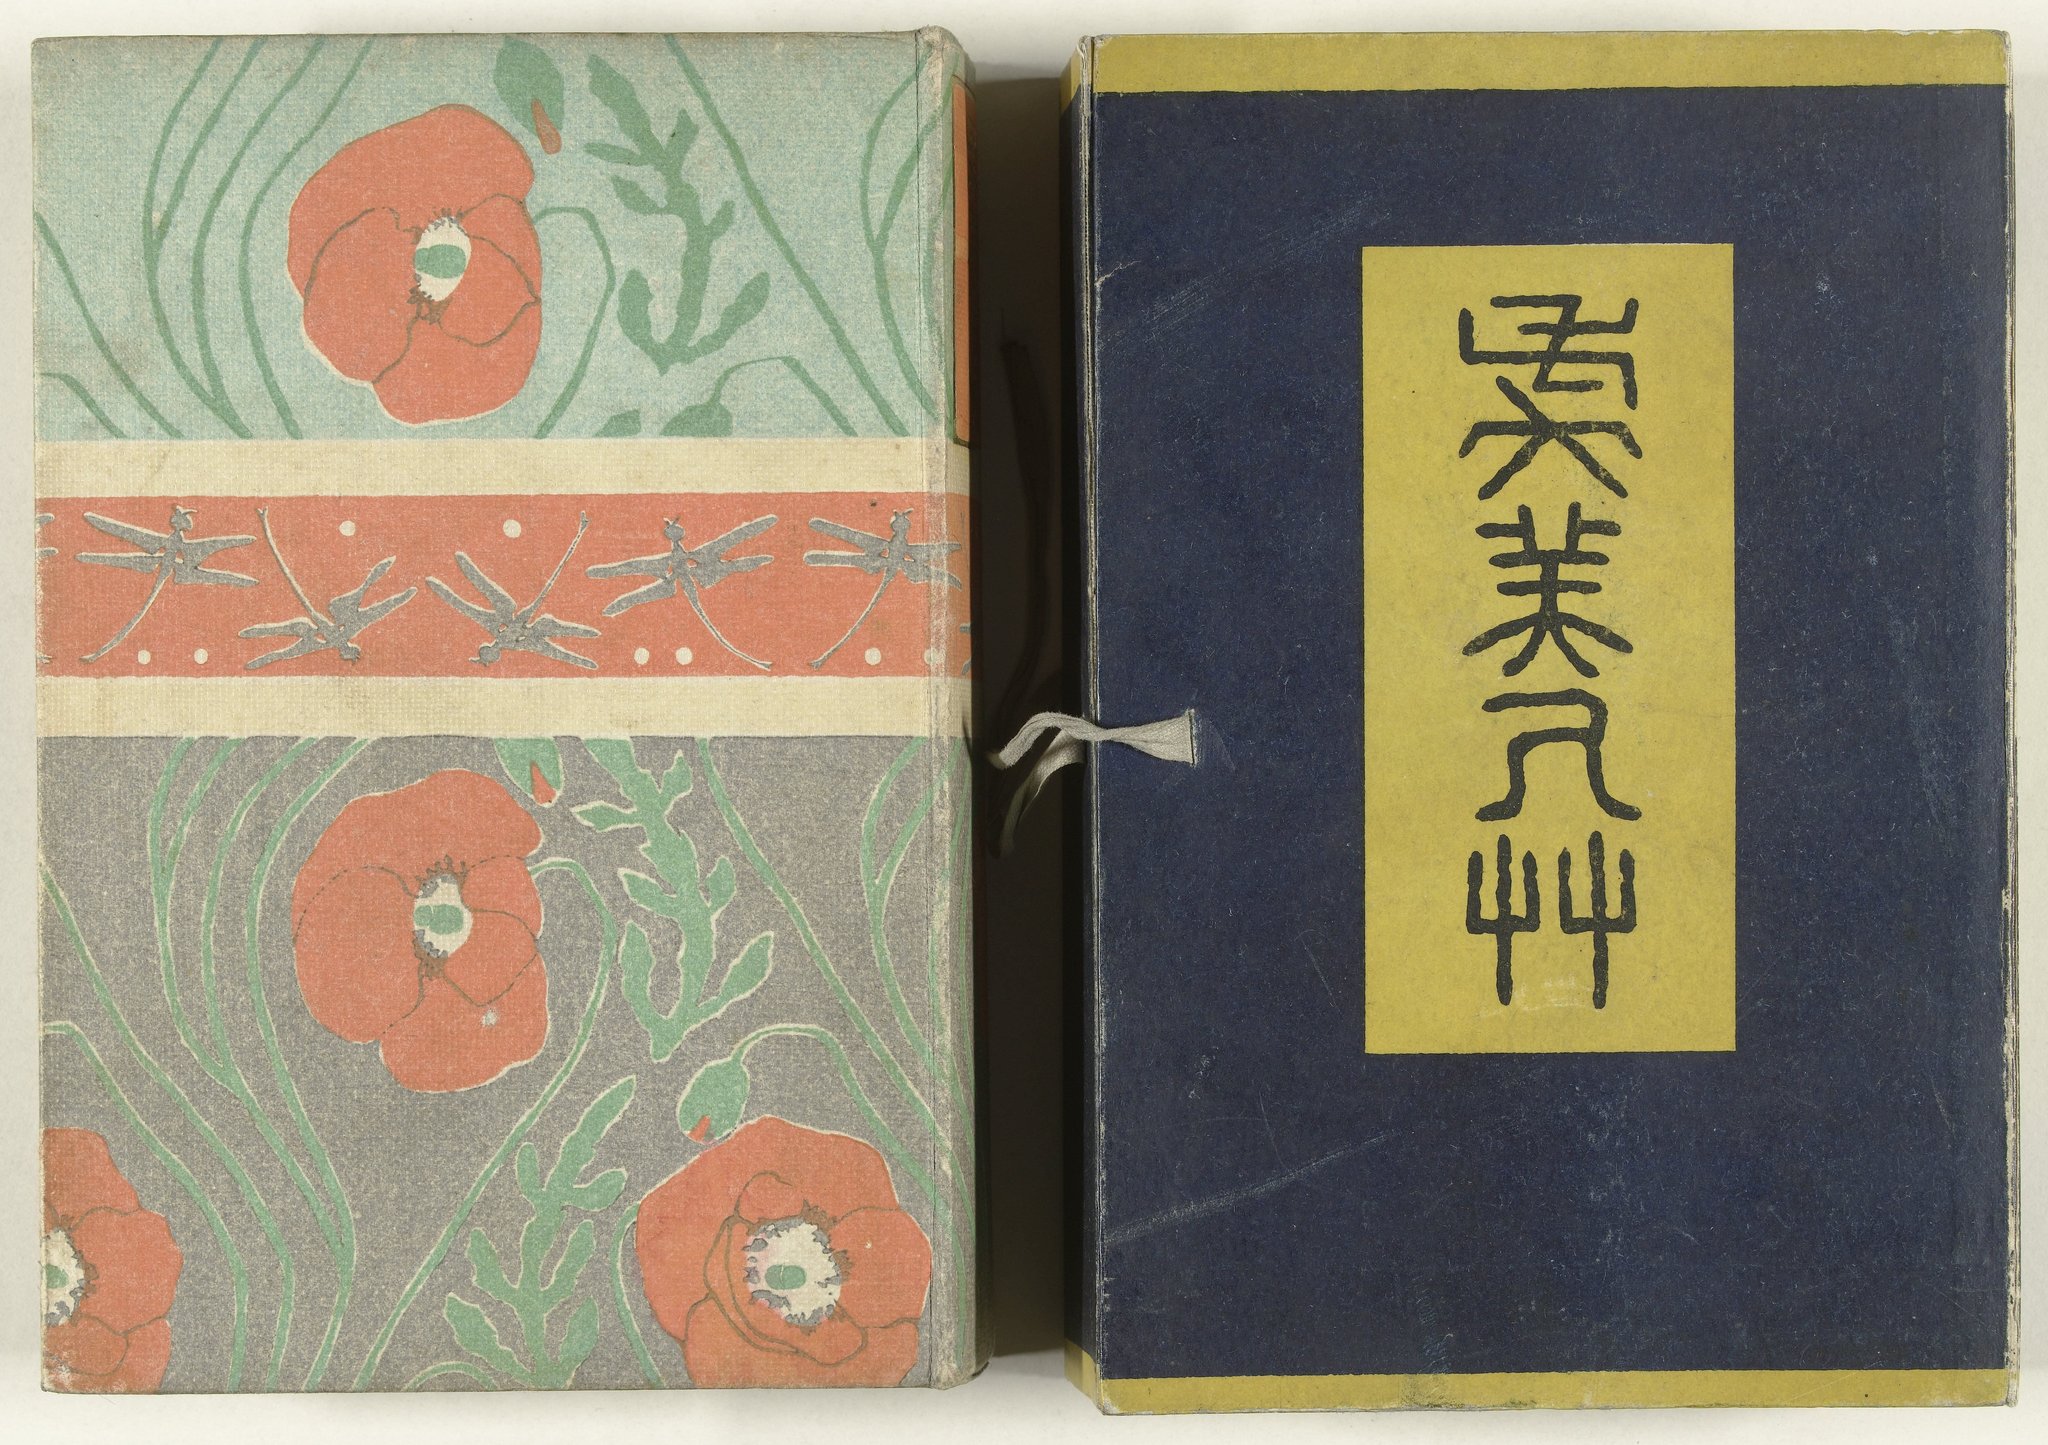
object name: book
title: Klaprozen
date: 1904-1908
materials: paper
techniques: woodcut, letterpress printing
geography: tokyo